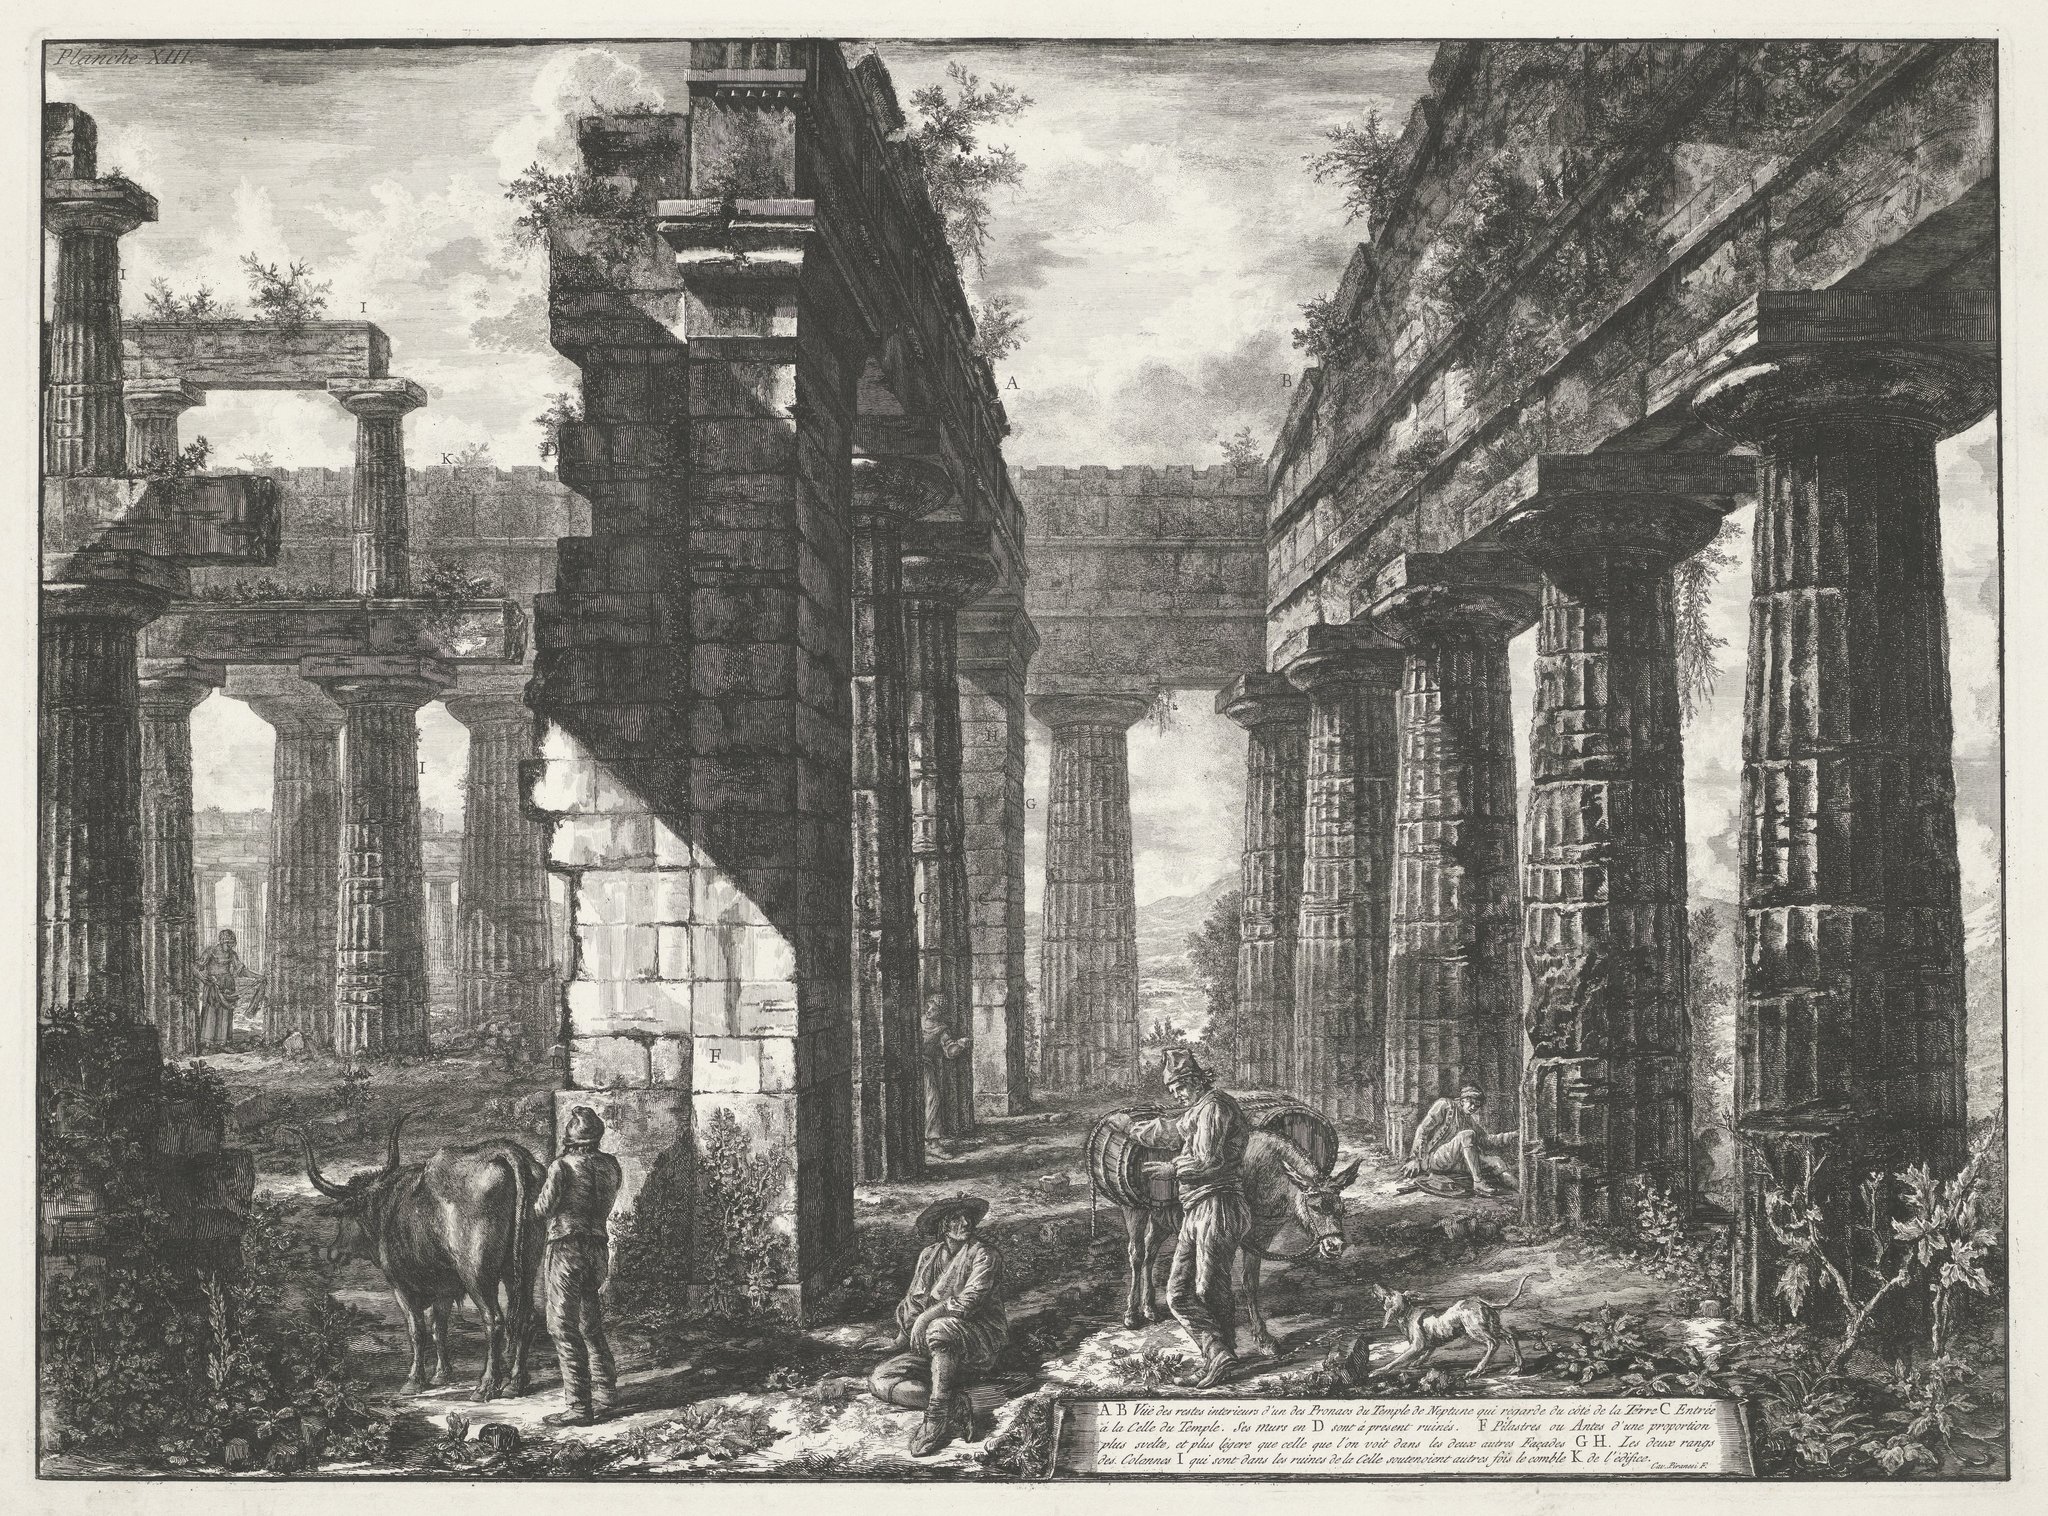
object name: print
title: Tempel van Neptunus te Paestum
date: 1778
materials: paper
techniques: etching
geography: rome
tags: (story of) neptune (poseidon), ruin of a building ~ architecture, landscape with ruins, temple, shrine ~ roman religion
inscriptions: collector's mark: Lugt 2760, collector's mark: Lugt 2228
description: Deze prent maakt deel uit van een reeks van 20 prenten (+ titelprent) met gezichten op tempels te Paestum. De gebouwen en de vegetatie op de prenten zijn uitgevoerd door Giovanni Battista Piranesi. De figuren zijn mogelijk uitgevoerd door zijn zoon Francesco.